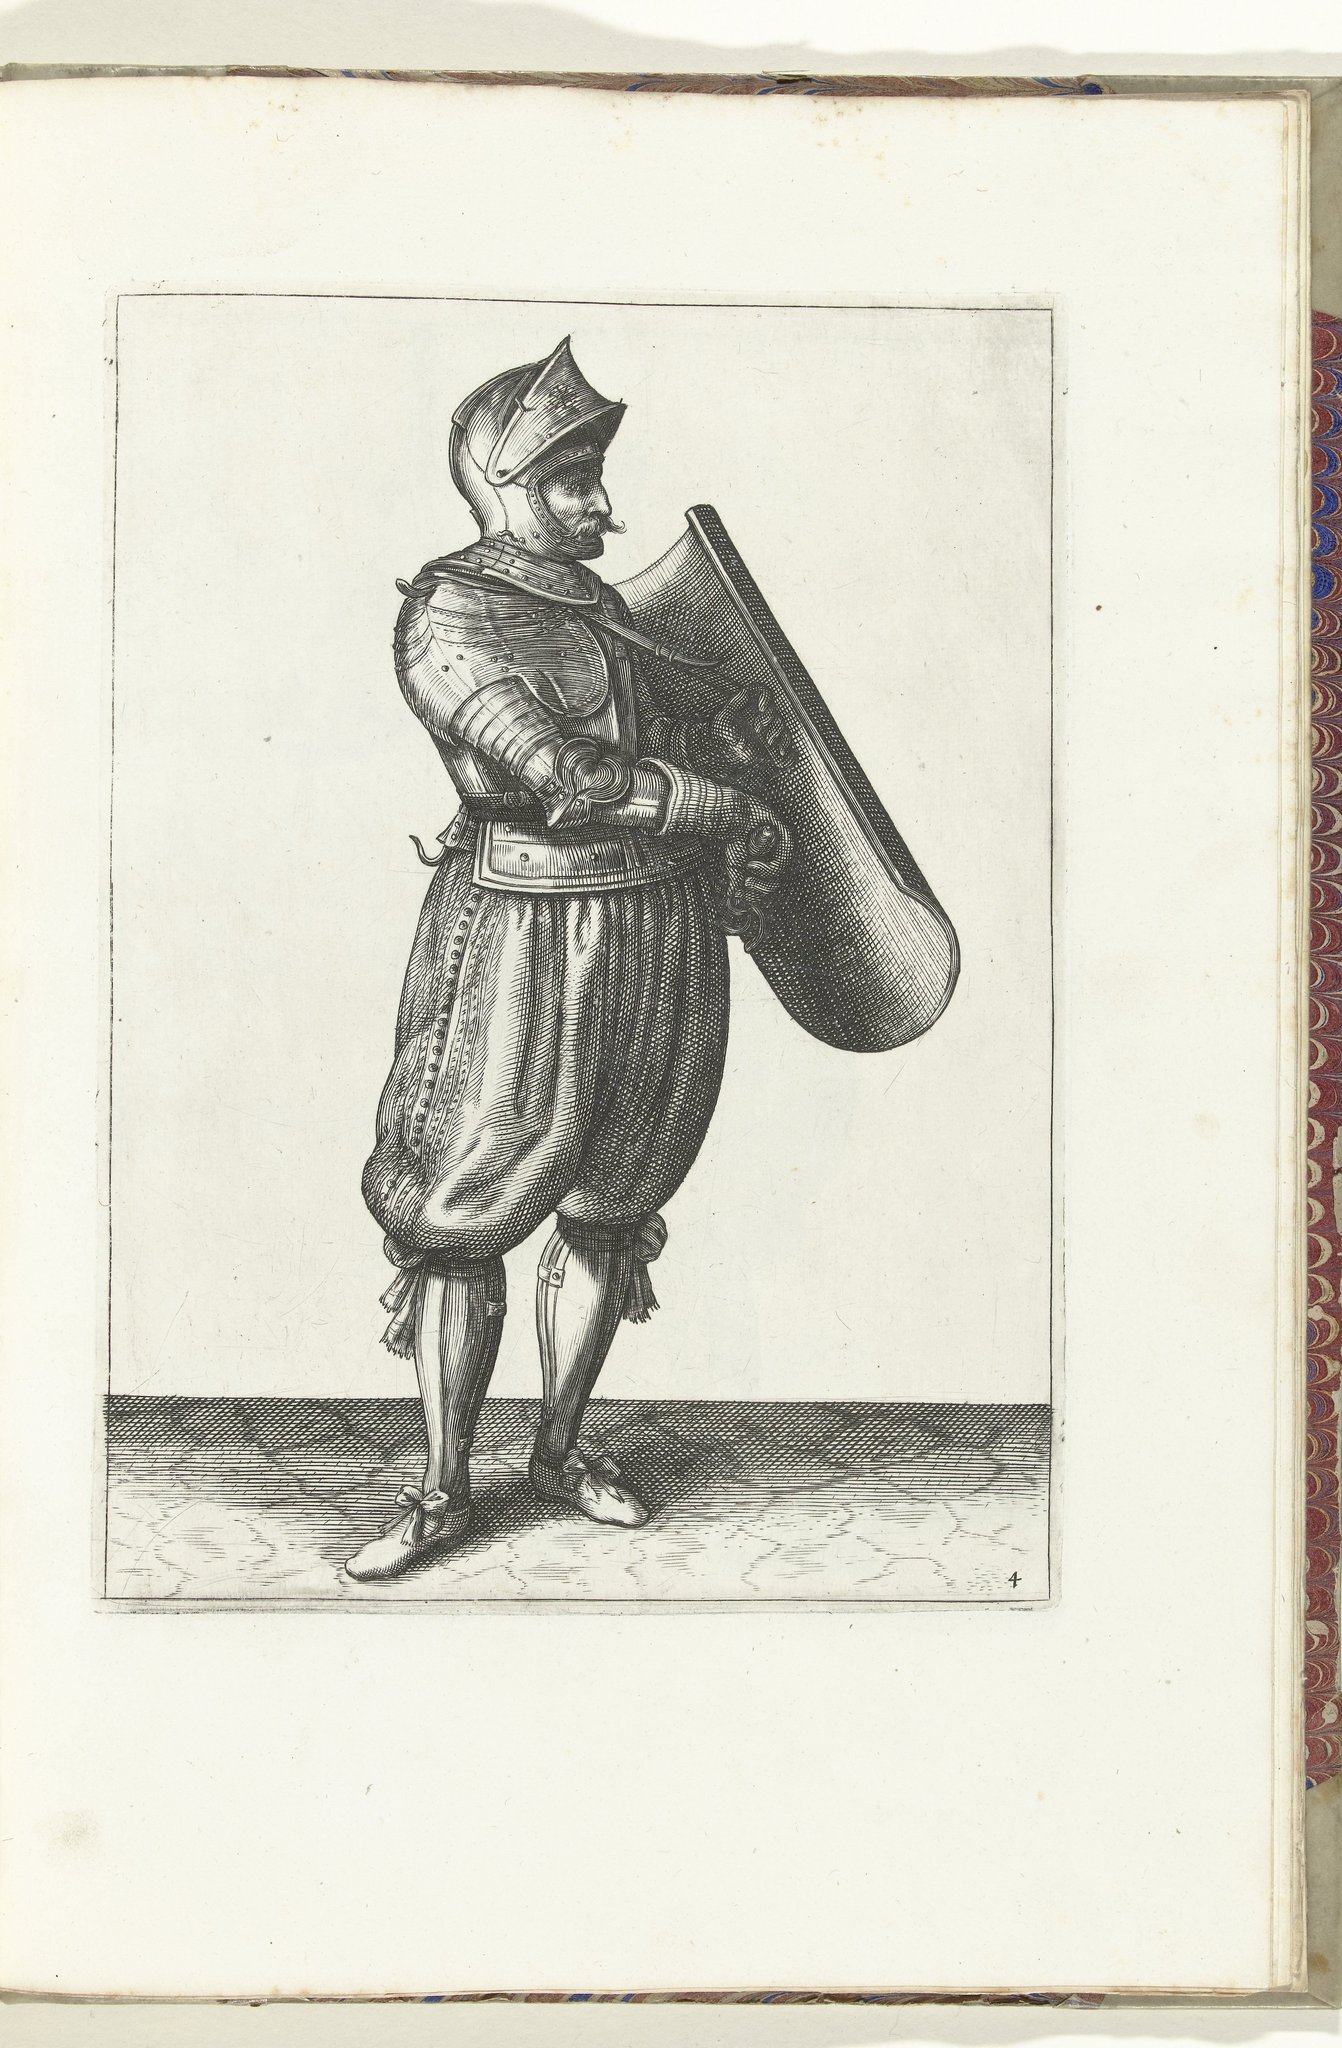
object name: print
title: De Nassausche Wapen-Handelinge, van Schilt, Spies, Rappier ende Targe : beyde figuerlick afgebeelt, ende gestelt na de nieu ordening [van] (...) Maurits van Nassau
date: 1616-1618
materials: paper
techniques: engraving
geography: northern netherlands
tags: the hague, maurice (prince of orange), handling of weapons ~ military training, weapons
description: Illustratie in: Adam van Breen, De Nassausche Wapen-Handelinge, van Schilt, Spies, Rappier ende Targe : beyde figuerlick afgebeelt, ende gestelt na de nieu ordening [van] ... Maurits van Nassau / Korte Onderwijsinge op de figuerlijcke af-beeldinghe belangende 'trecht ghebruyck van al 'tghene een Soldaet noodigh is in het handelen vande Targes met het Rappier, 's-Gravenhage, [Aert Meuris] 1618, plaat nr. 4. In het exemplaar in de collectie van de Rijksmuseum Research Library (326 F 22).